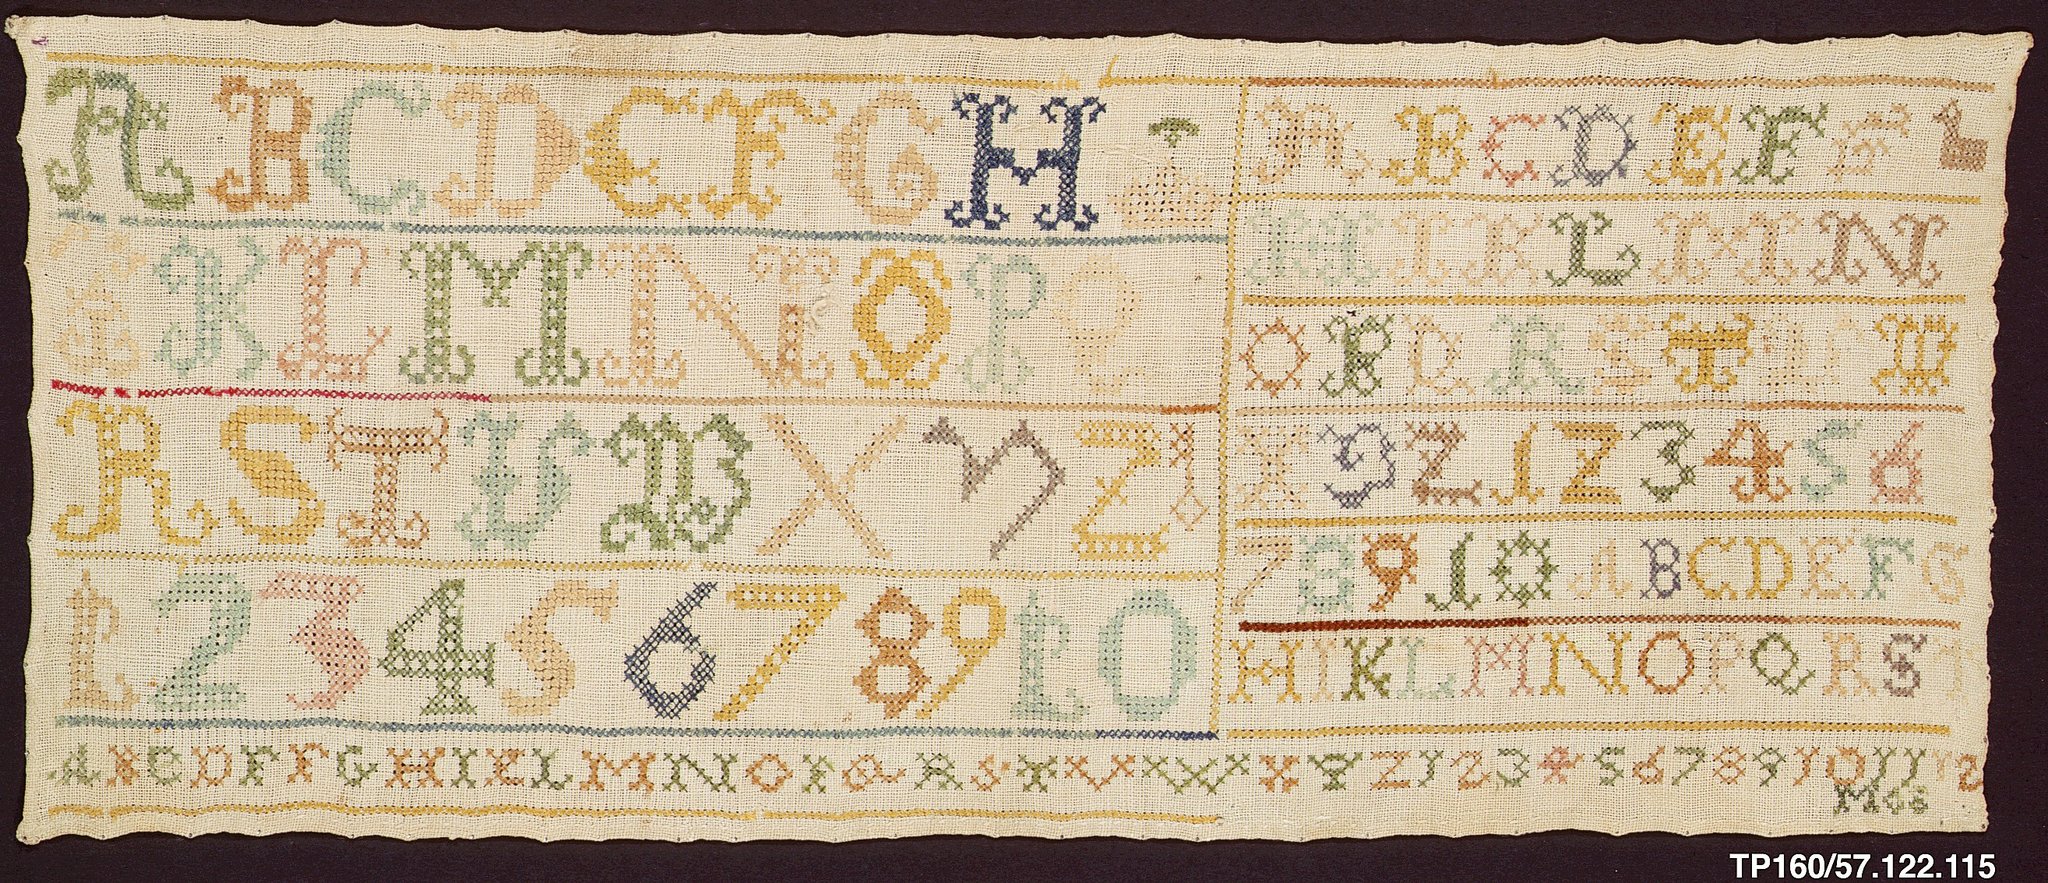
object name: sampler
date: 1701-1800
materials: linen, silk